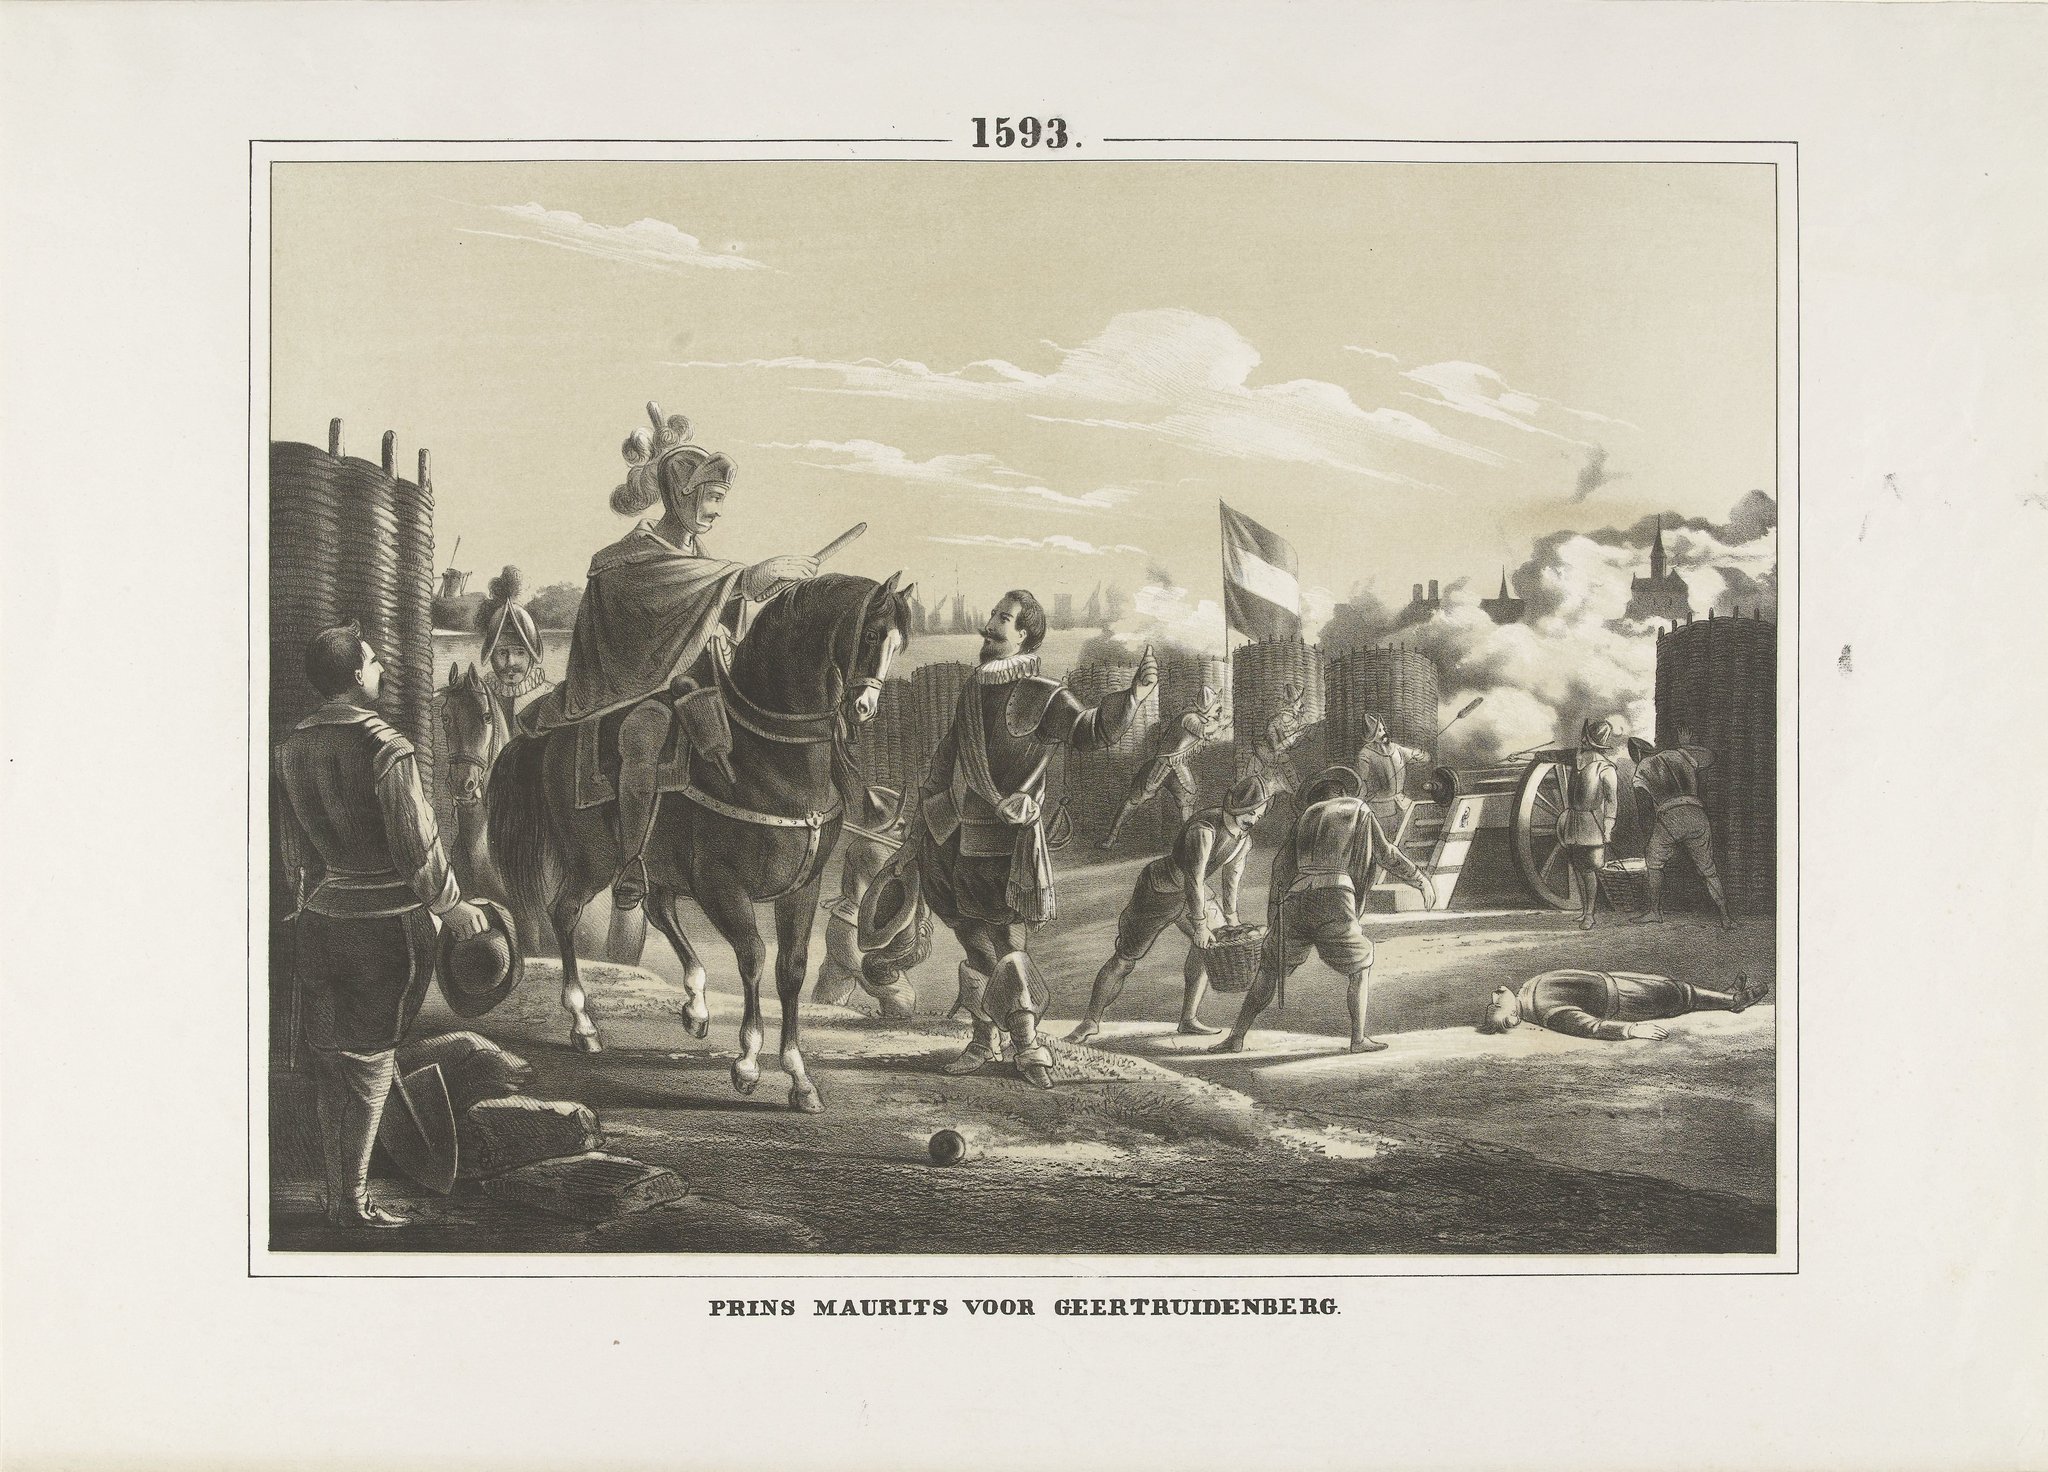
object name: history print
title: 1593 / Prins Maurits voor Geertruidenberg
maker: Anonymous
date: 1853-1855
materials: paper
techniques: tone lithography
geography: netherlands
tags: maurice (prince of orange), siege, position war, geertruidenberg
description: Gebruikt als illustratie in: J.H. Eichman & H. Altmann, Vaderlandsche historieplaten voor scholen en huisgezinnen, Leiden, 1855. Dit nummer is een door het RPK toegevoegd nummer en staat niet in Frederik Muller, het werk waar de prent voor is gemaakt of uit afkomstig is, staat wel vermeld in Frederik Muller.